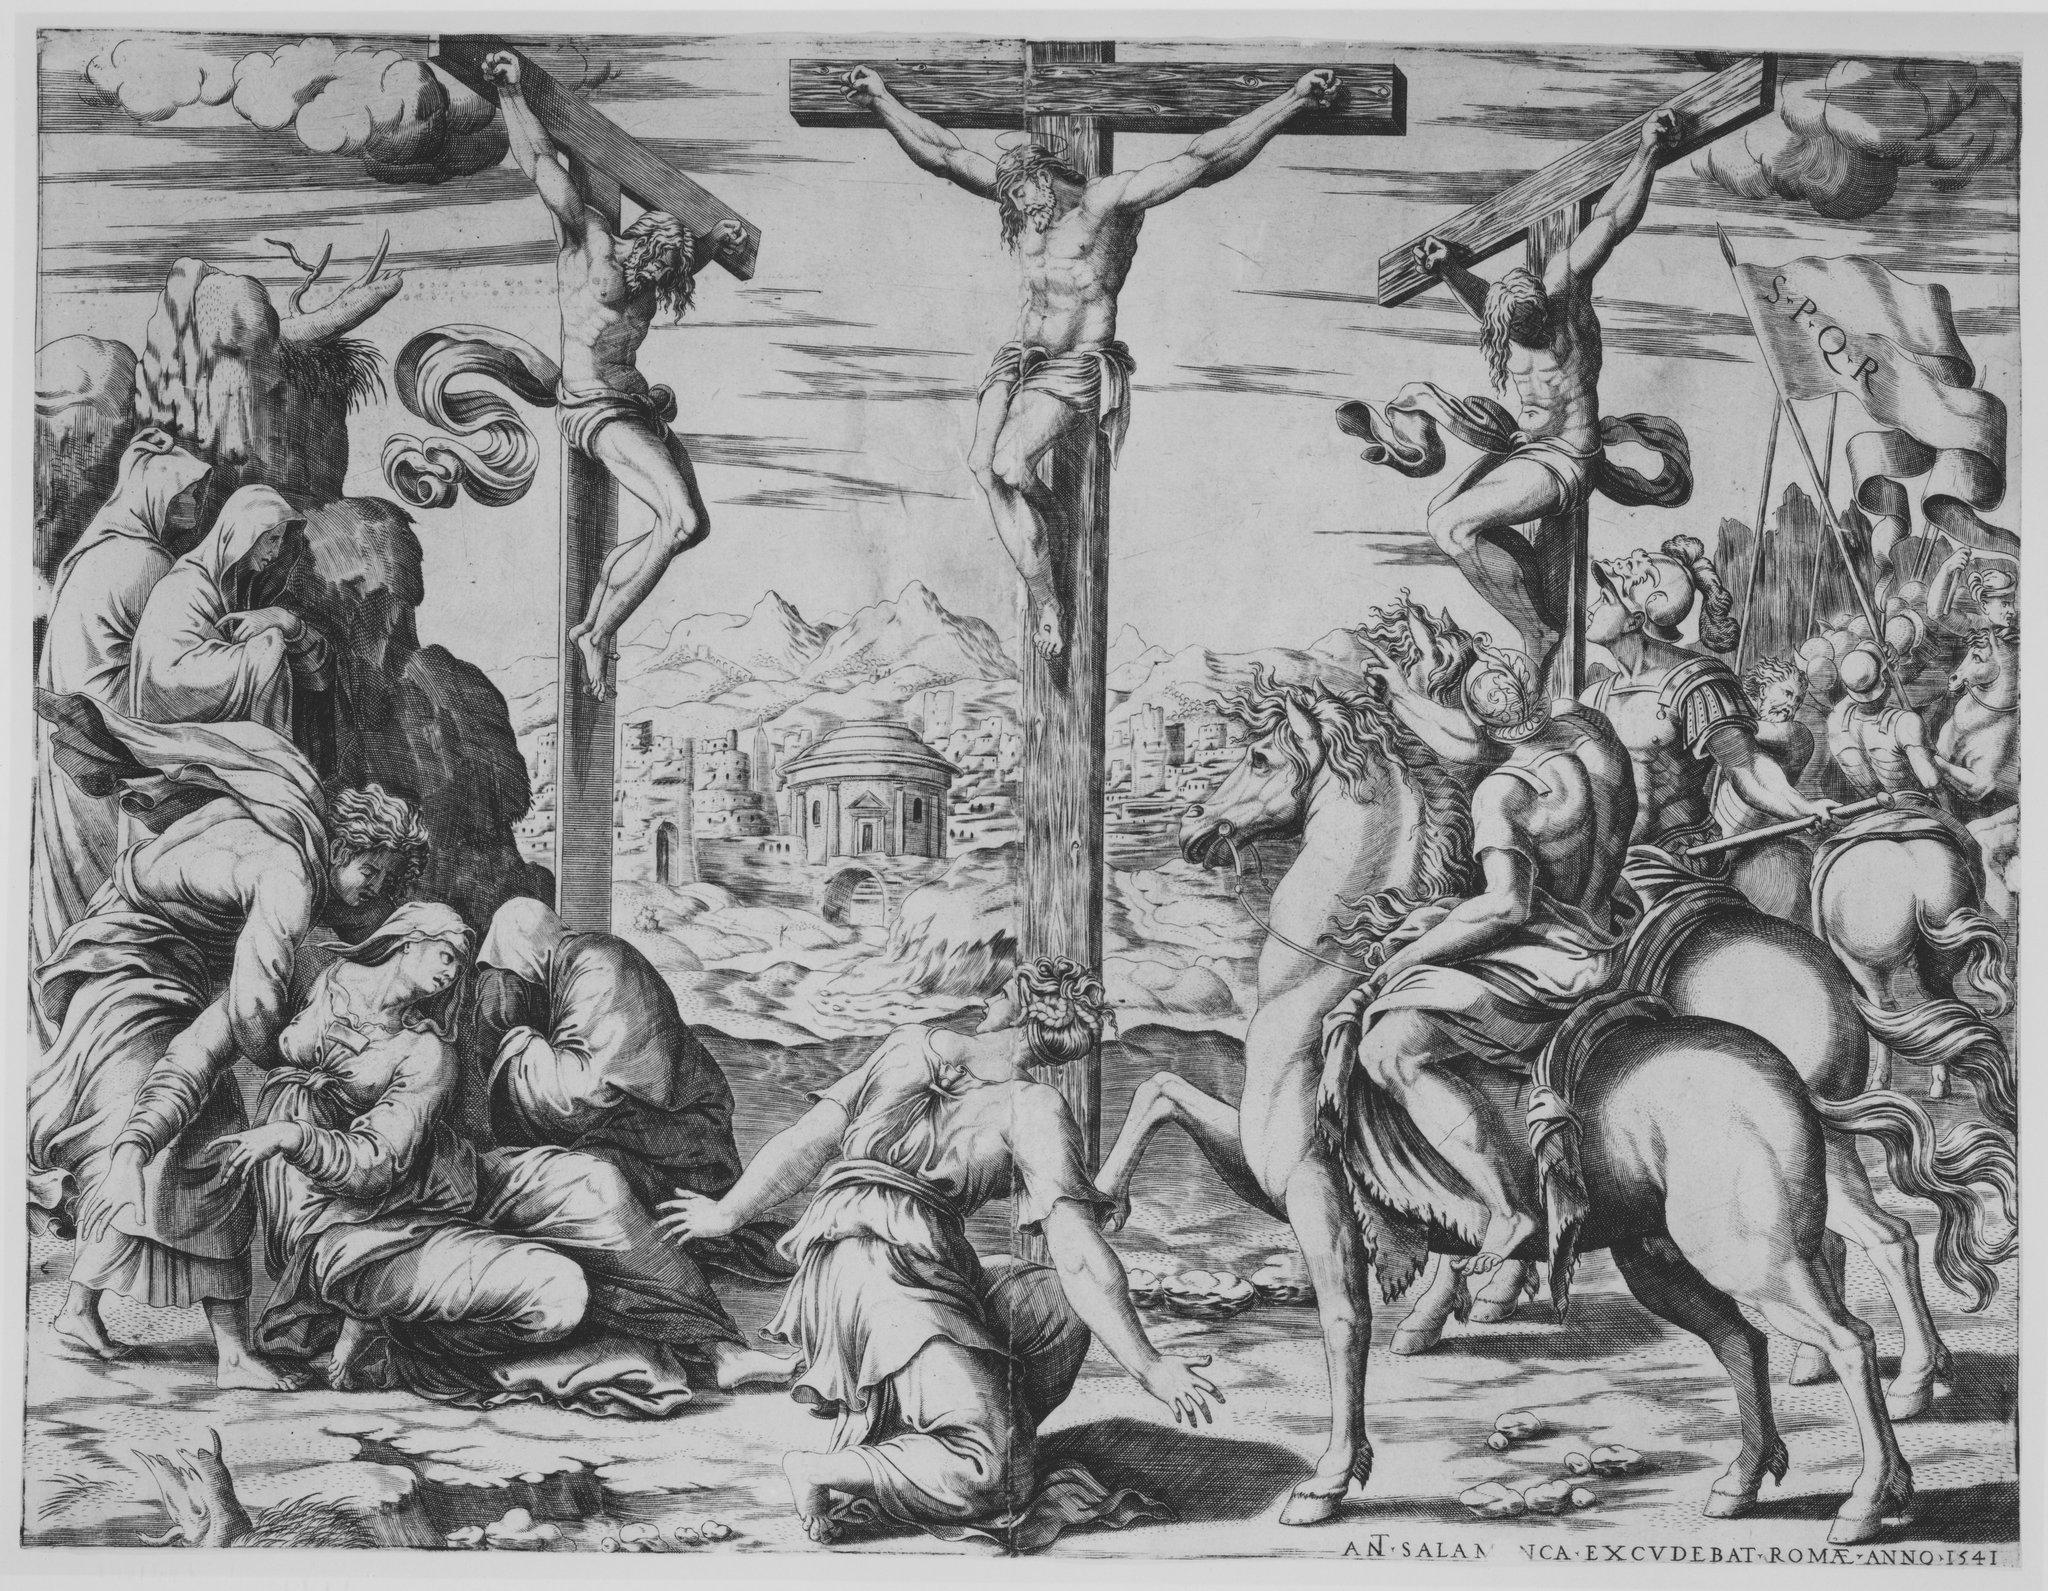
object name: print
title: Crucifixion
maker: anonymous, italian, 16th century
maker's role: engraver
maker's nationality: italian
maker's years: 1500-1600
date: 1541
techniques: engraving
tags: horses,crucifixion